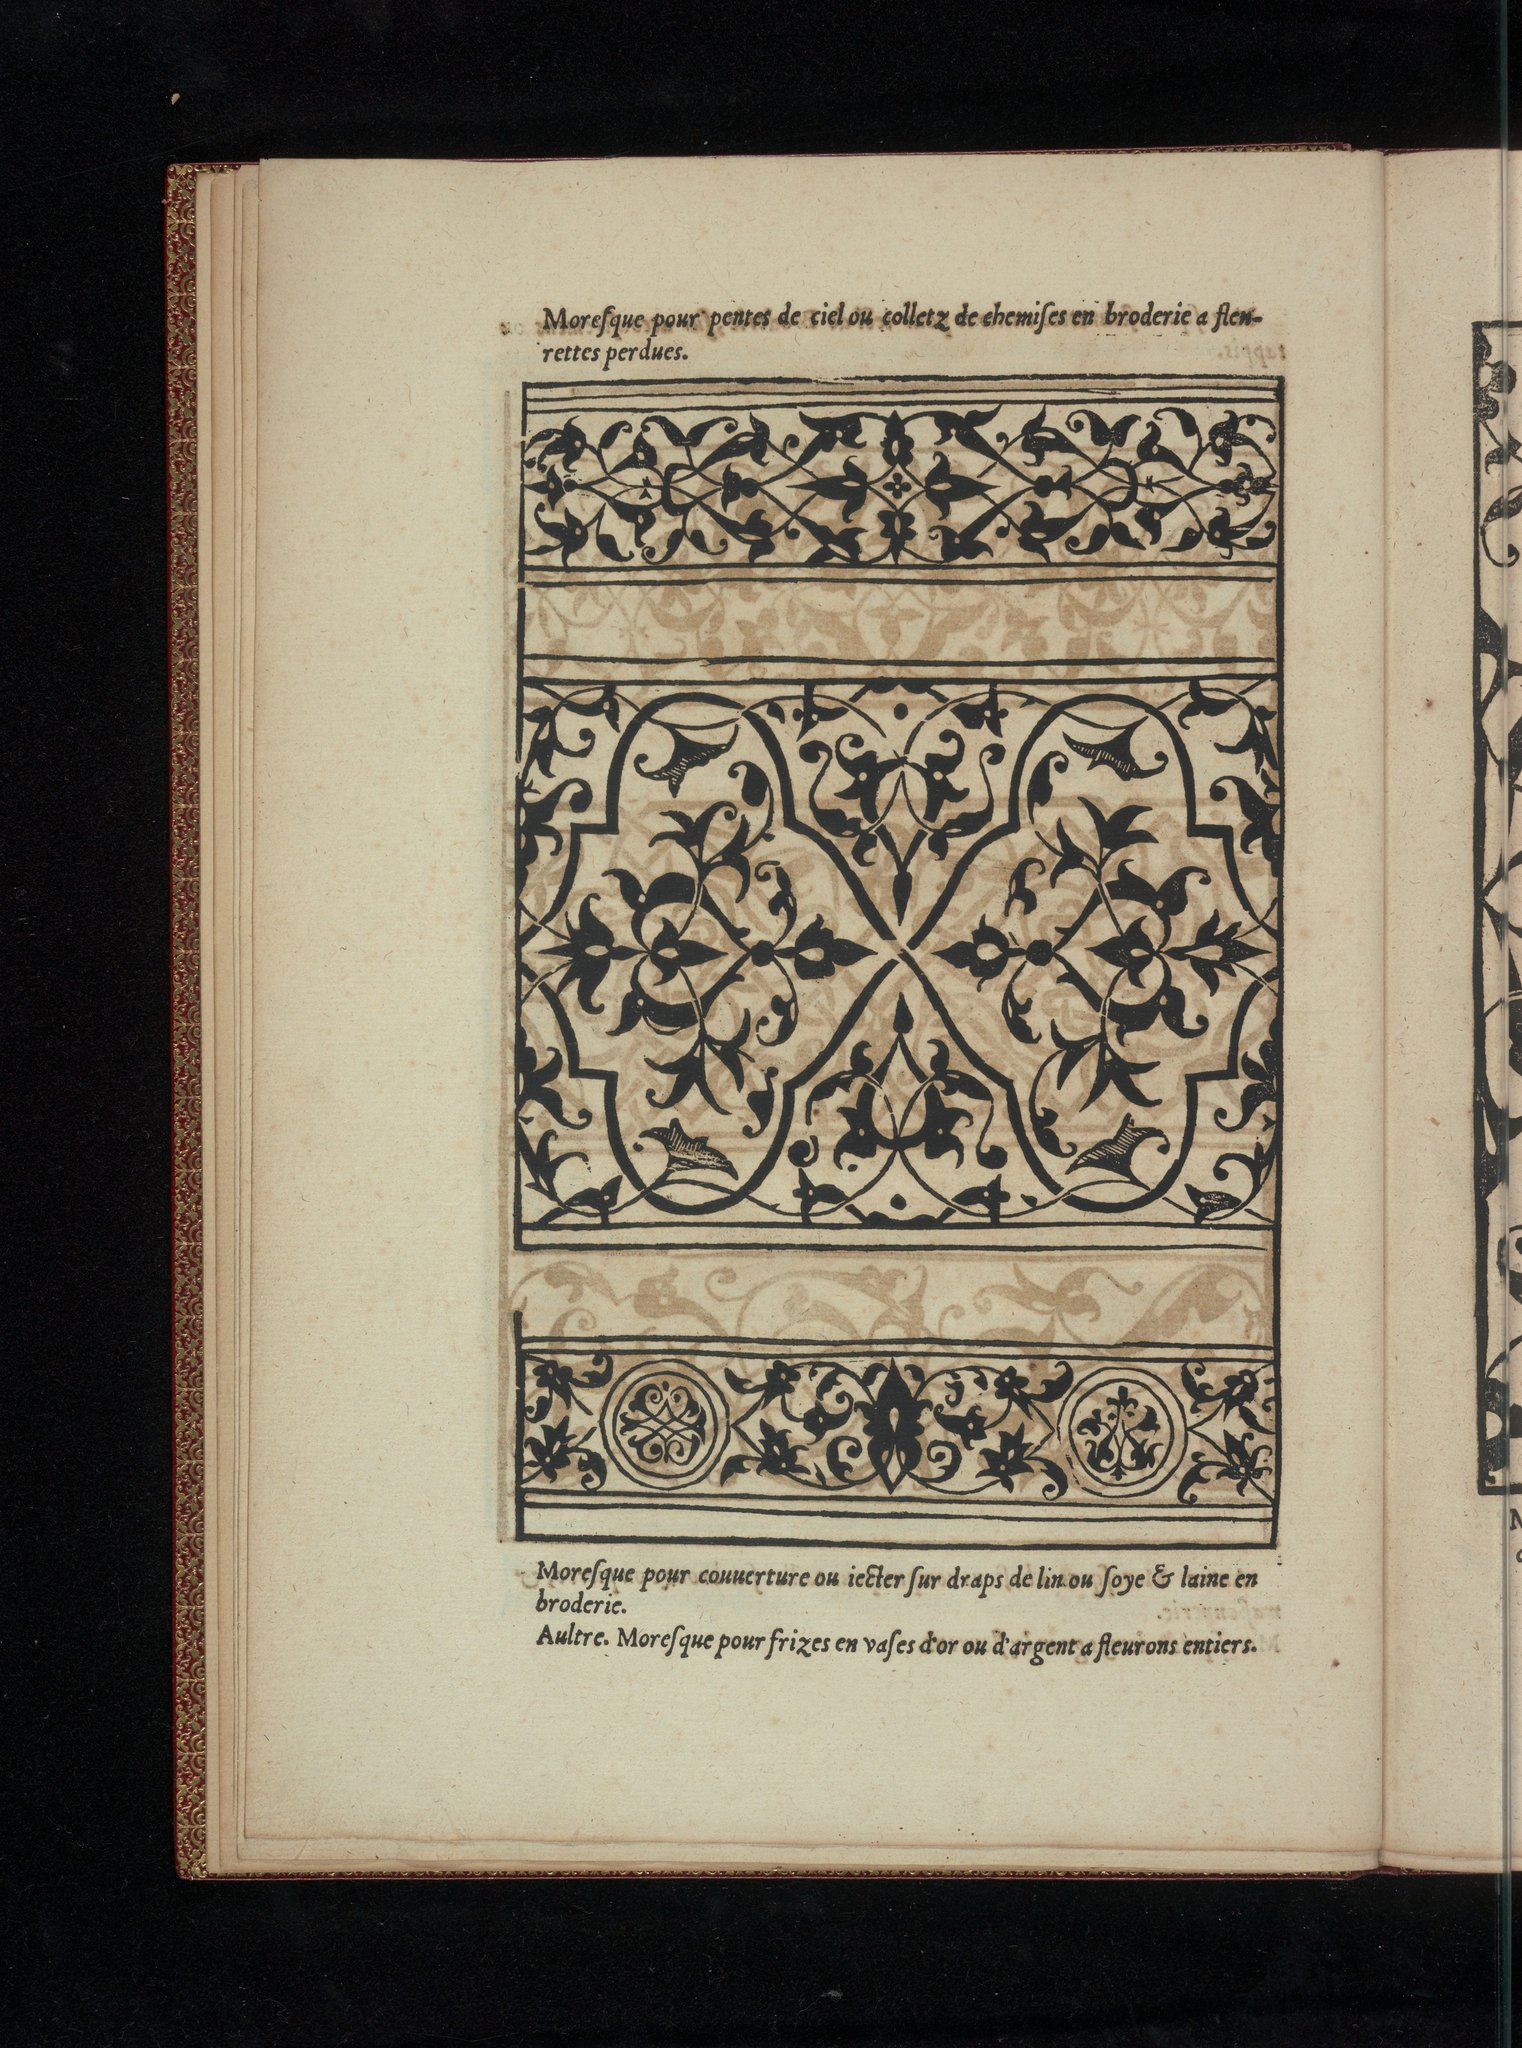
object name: book print ornament architecture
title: Livre de Moresques, page 2 (verso)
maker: francesco di pellegrino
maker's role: artist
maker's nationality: italian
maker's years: 1525-1552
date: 1546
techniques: woodcut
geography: france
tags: ornament